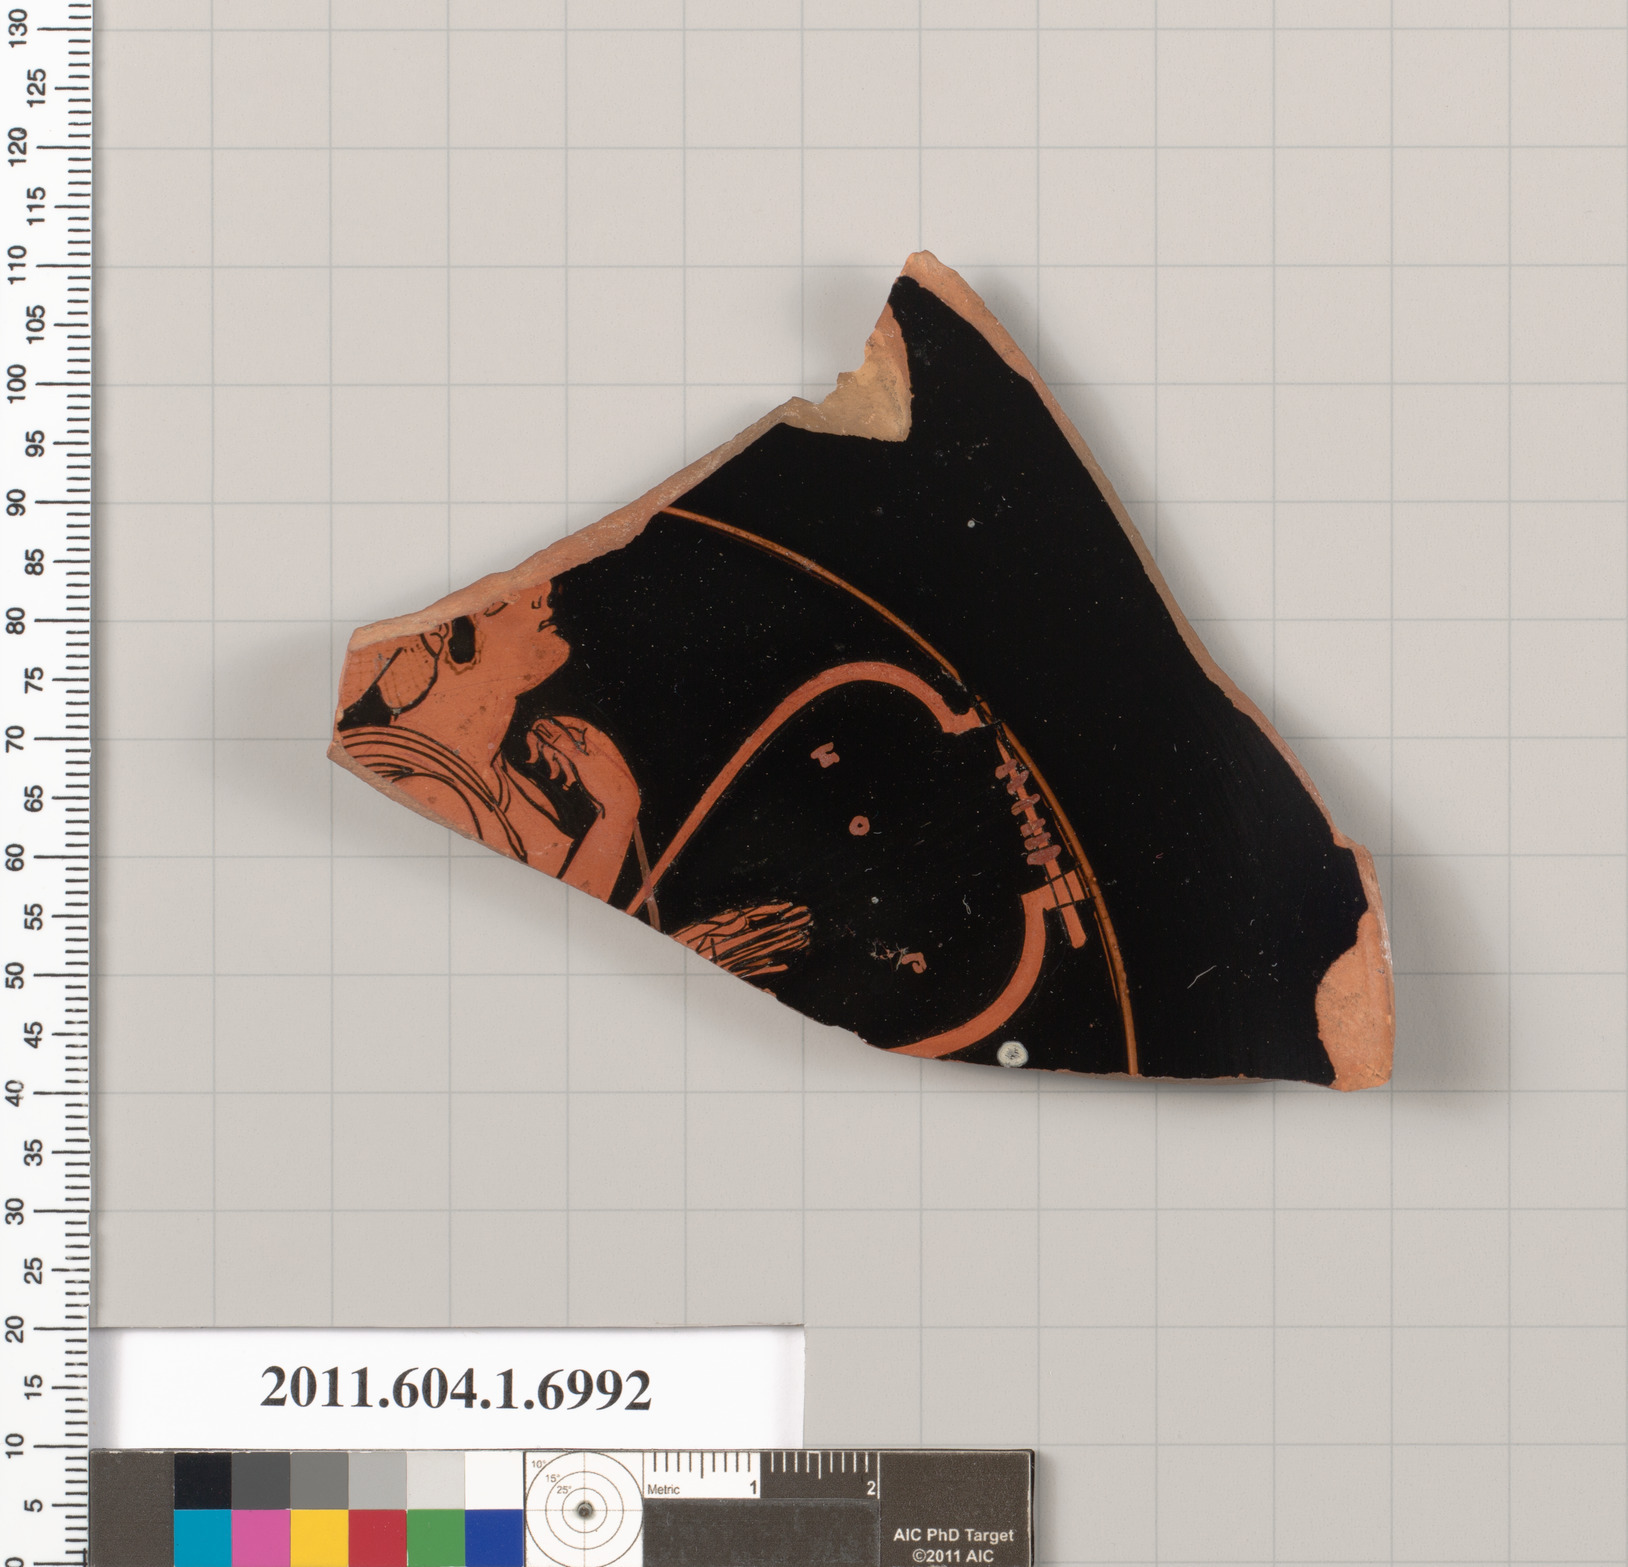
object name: kylix fragment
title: Terracotta fragment of a kylix (drinking cup)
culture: greek, attic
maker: douris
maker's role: artist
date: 500-480 BCE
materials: terracotta